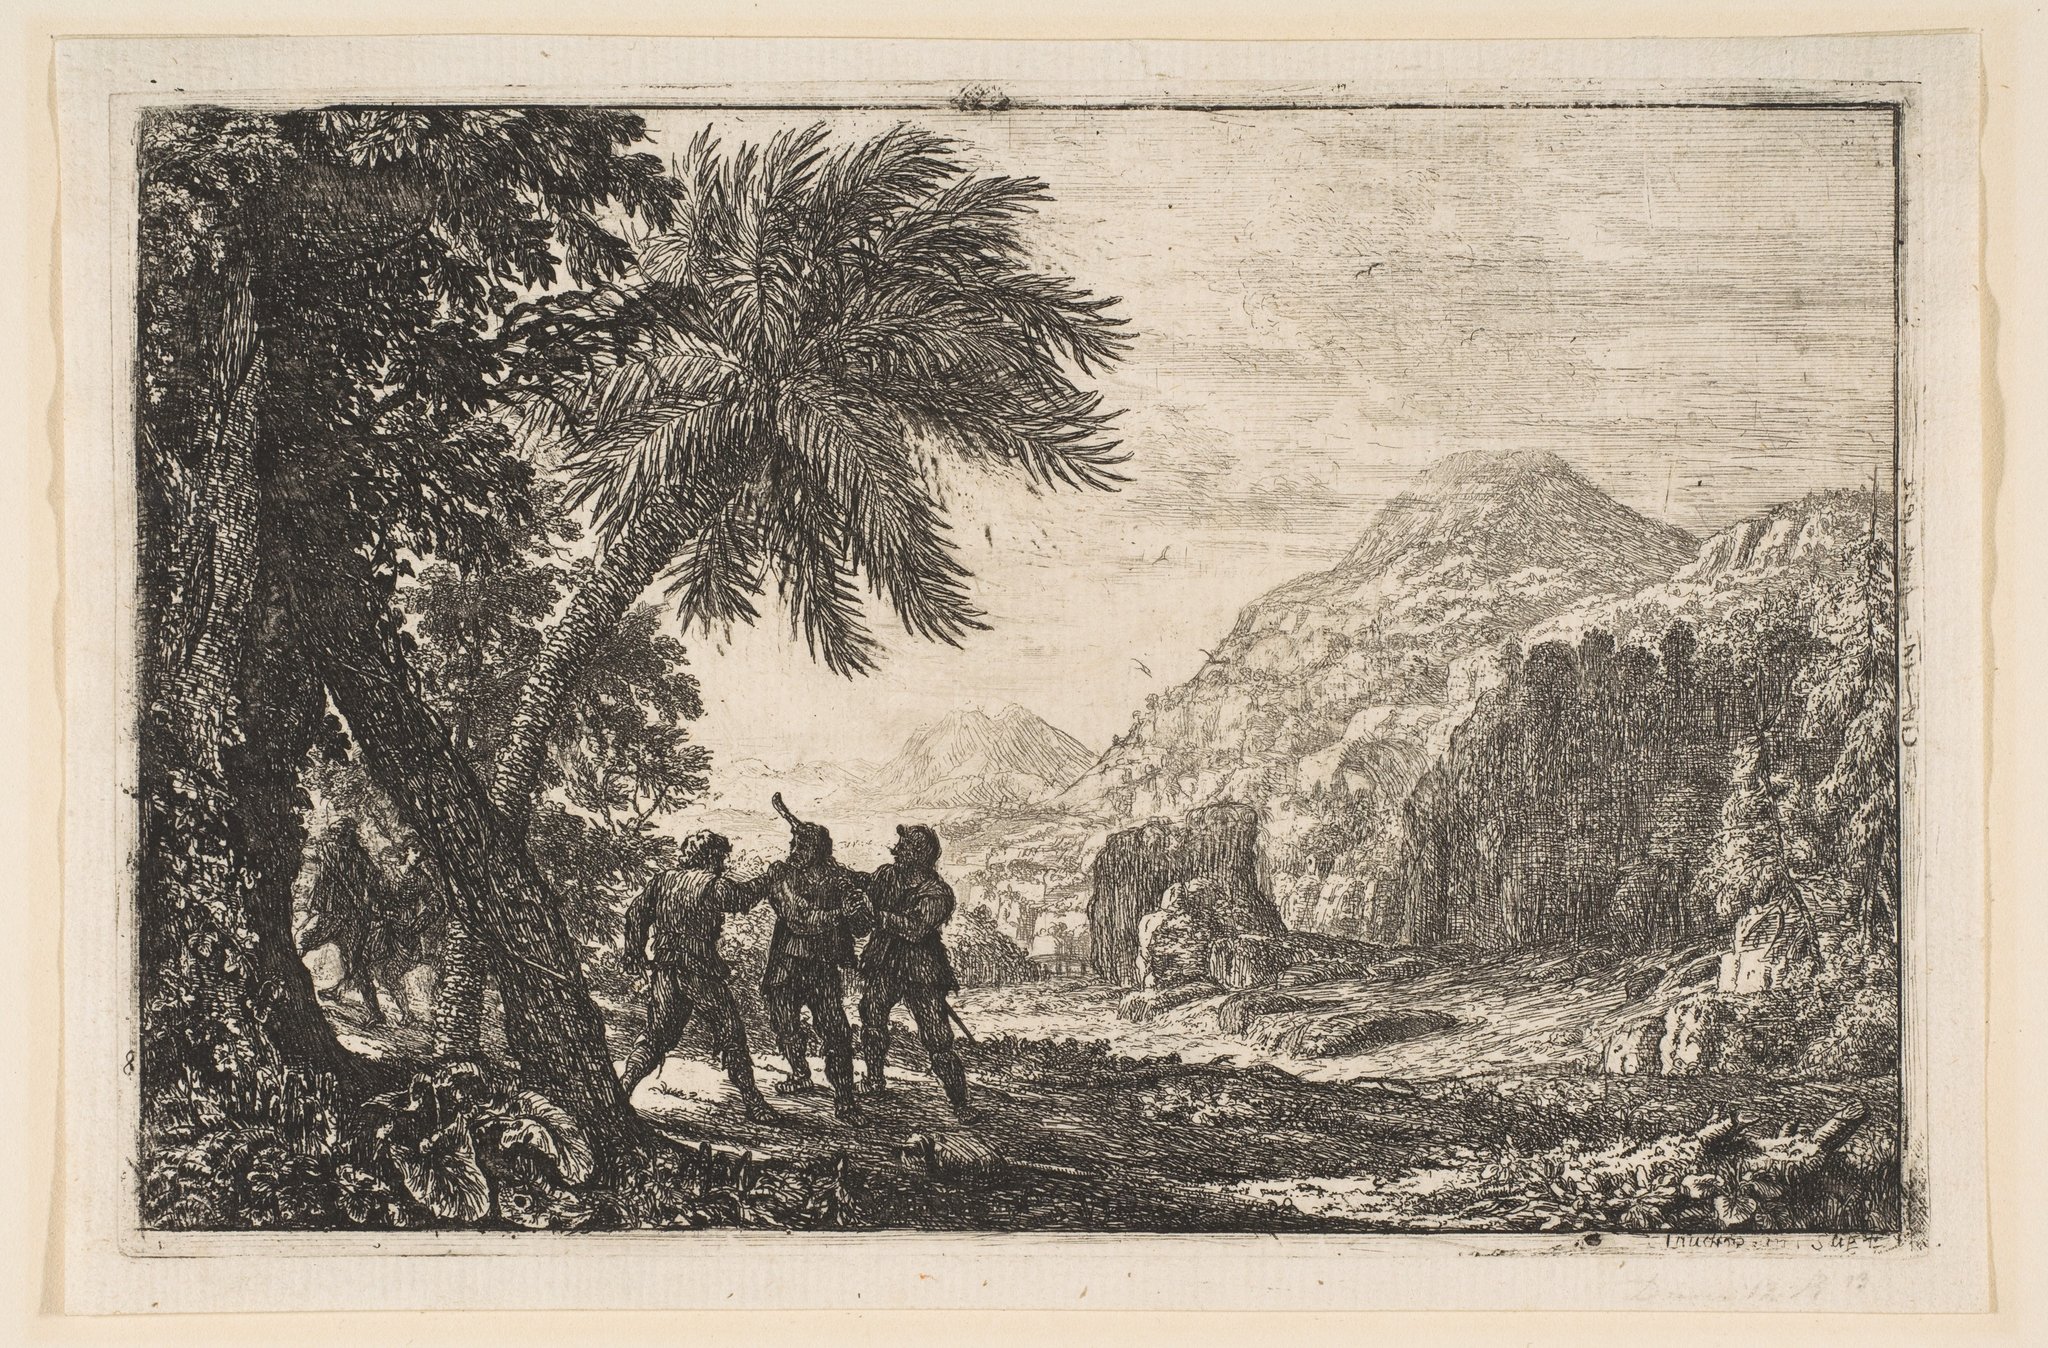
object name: print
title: Landscape with Brigands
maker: claude lorrain (claude gellée)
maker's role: artist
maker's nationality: french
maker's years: 1604-1682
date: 1633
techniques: etching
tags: men,mountains,landscapes,trees